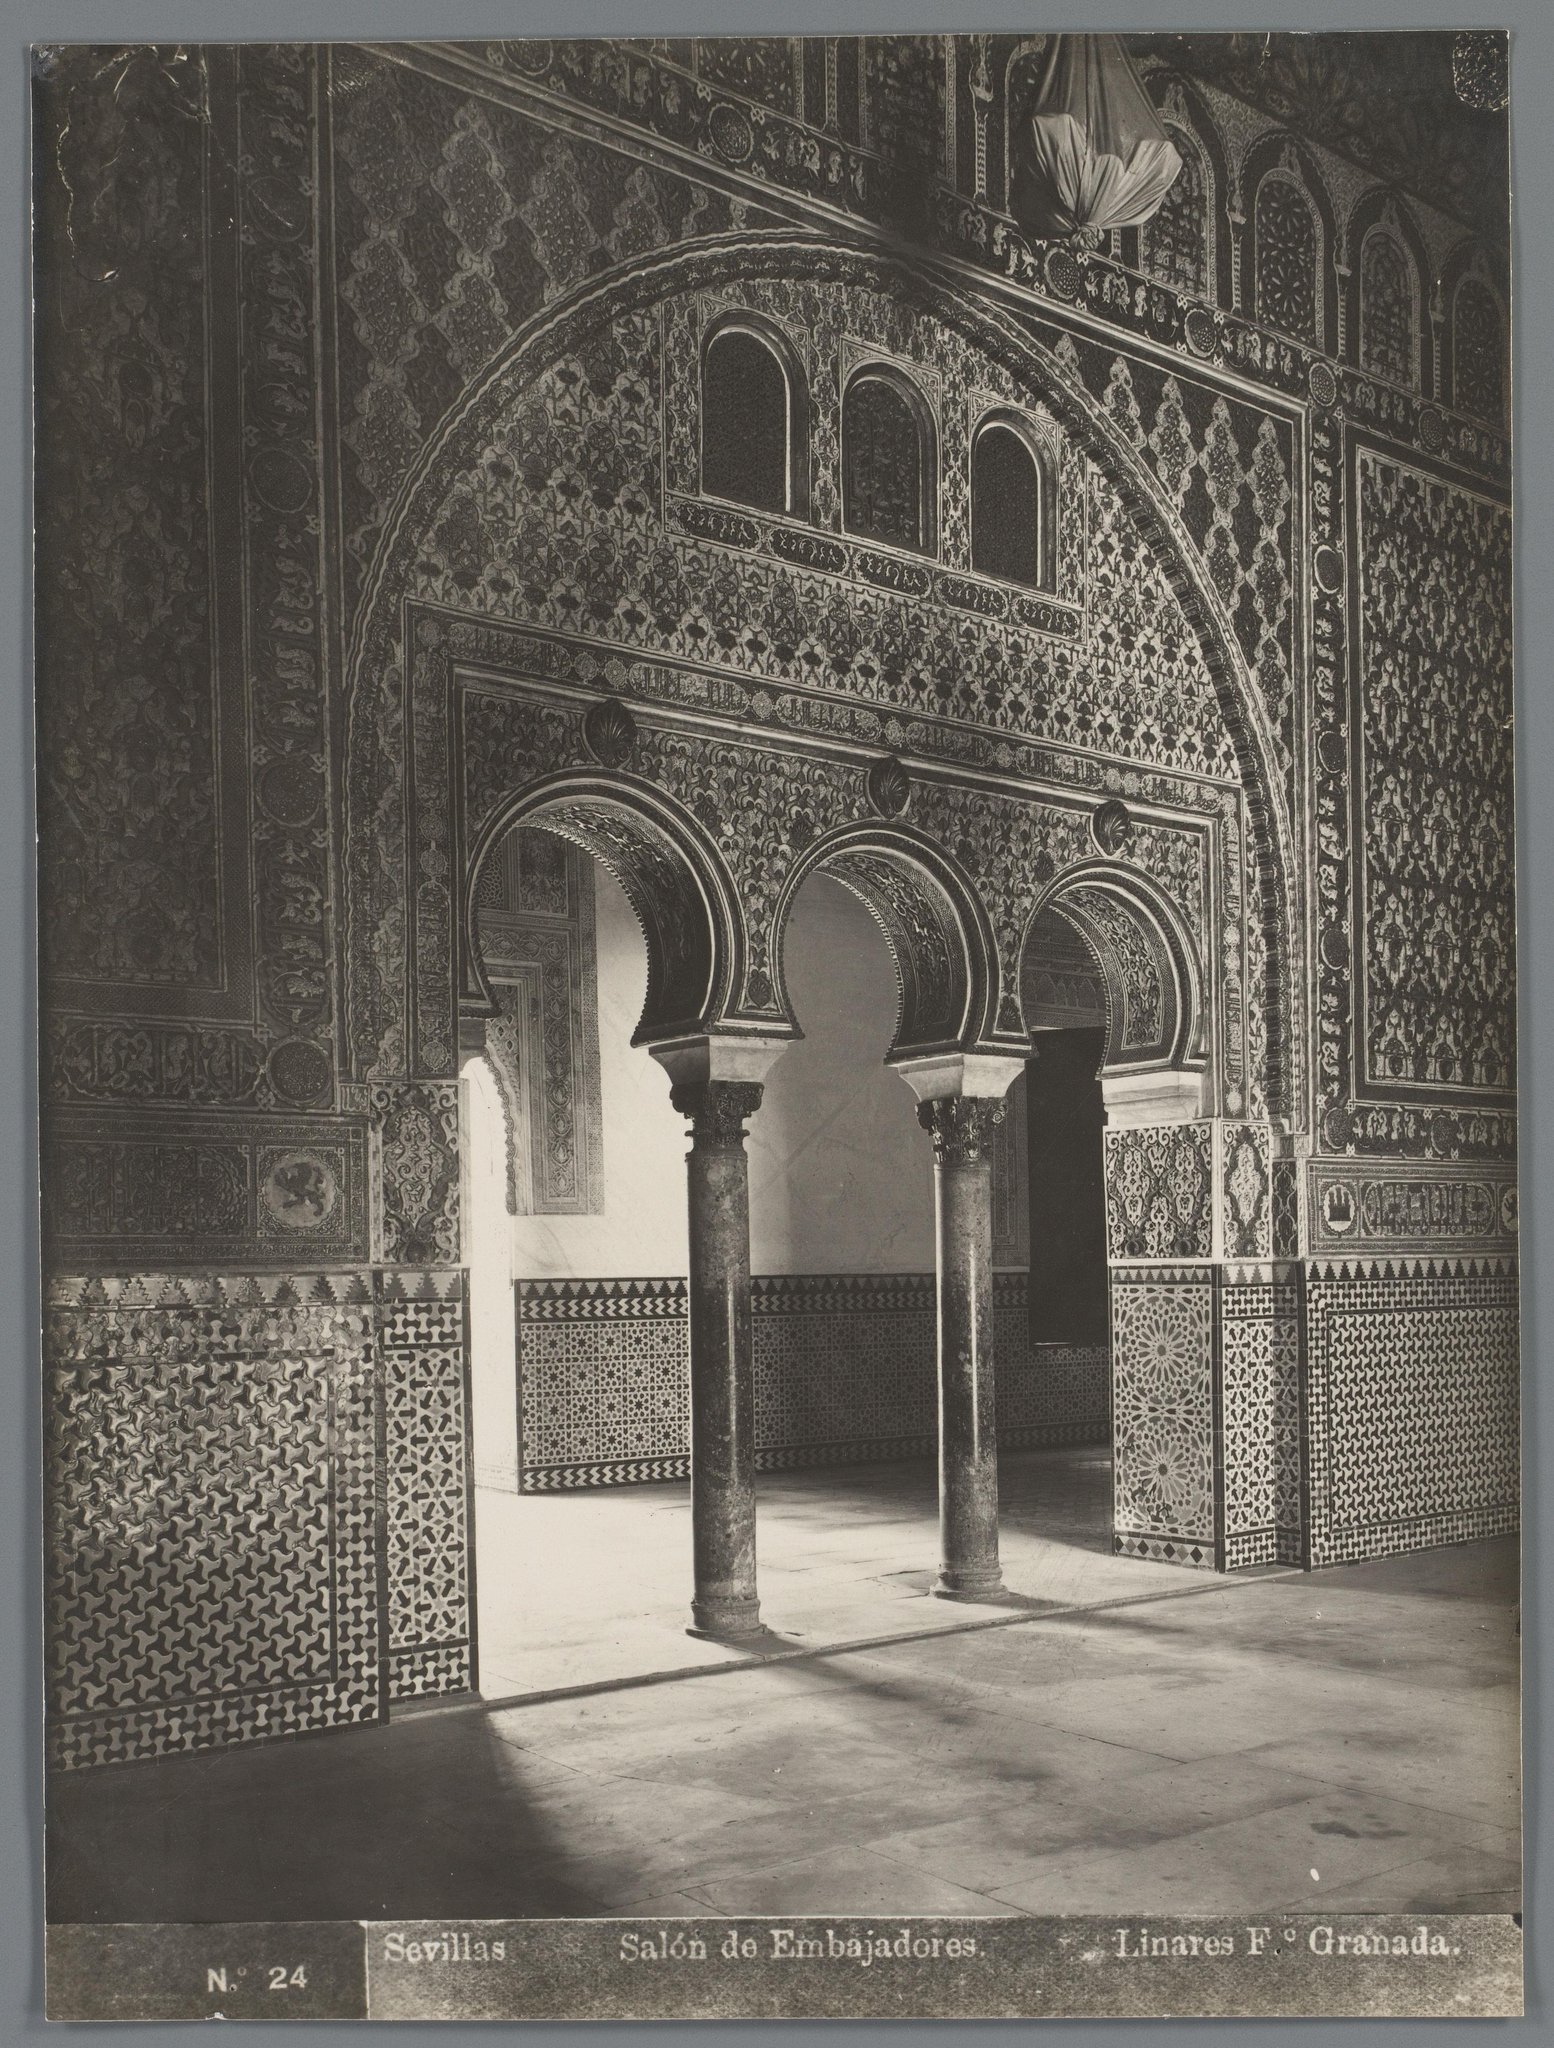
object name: photograph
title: Sevillas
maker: f. linares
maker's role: publisher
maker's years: 1870-1937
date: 1914-1937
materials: photographic support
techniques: gelatin silver print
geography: sevilla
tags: palace, stuccoeing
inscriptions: number: ‘No. 24’